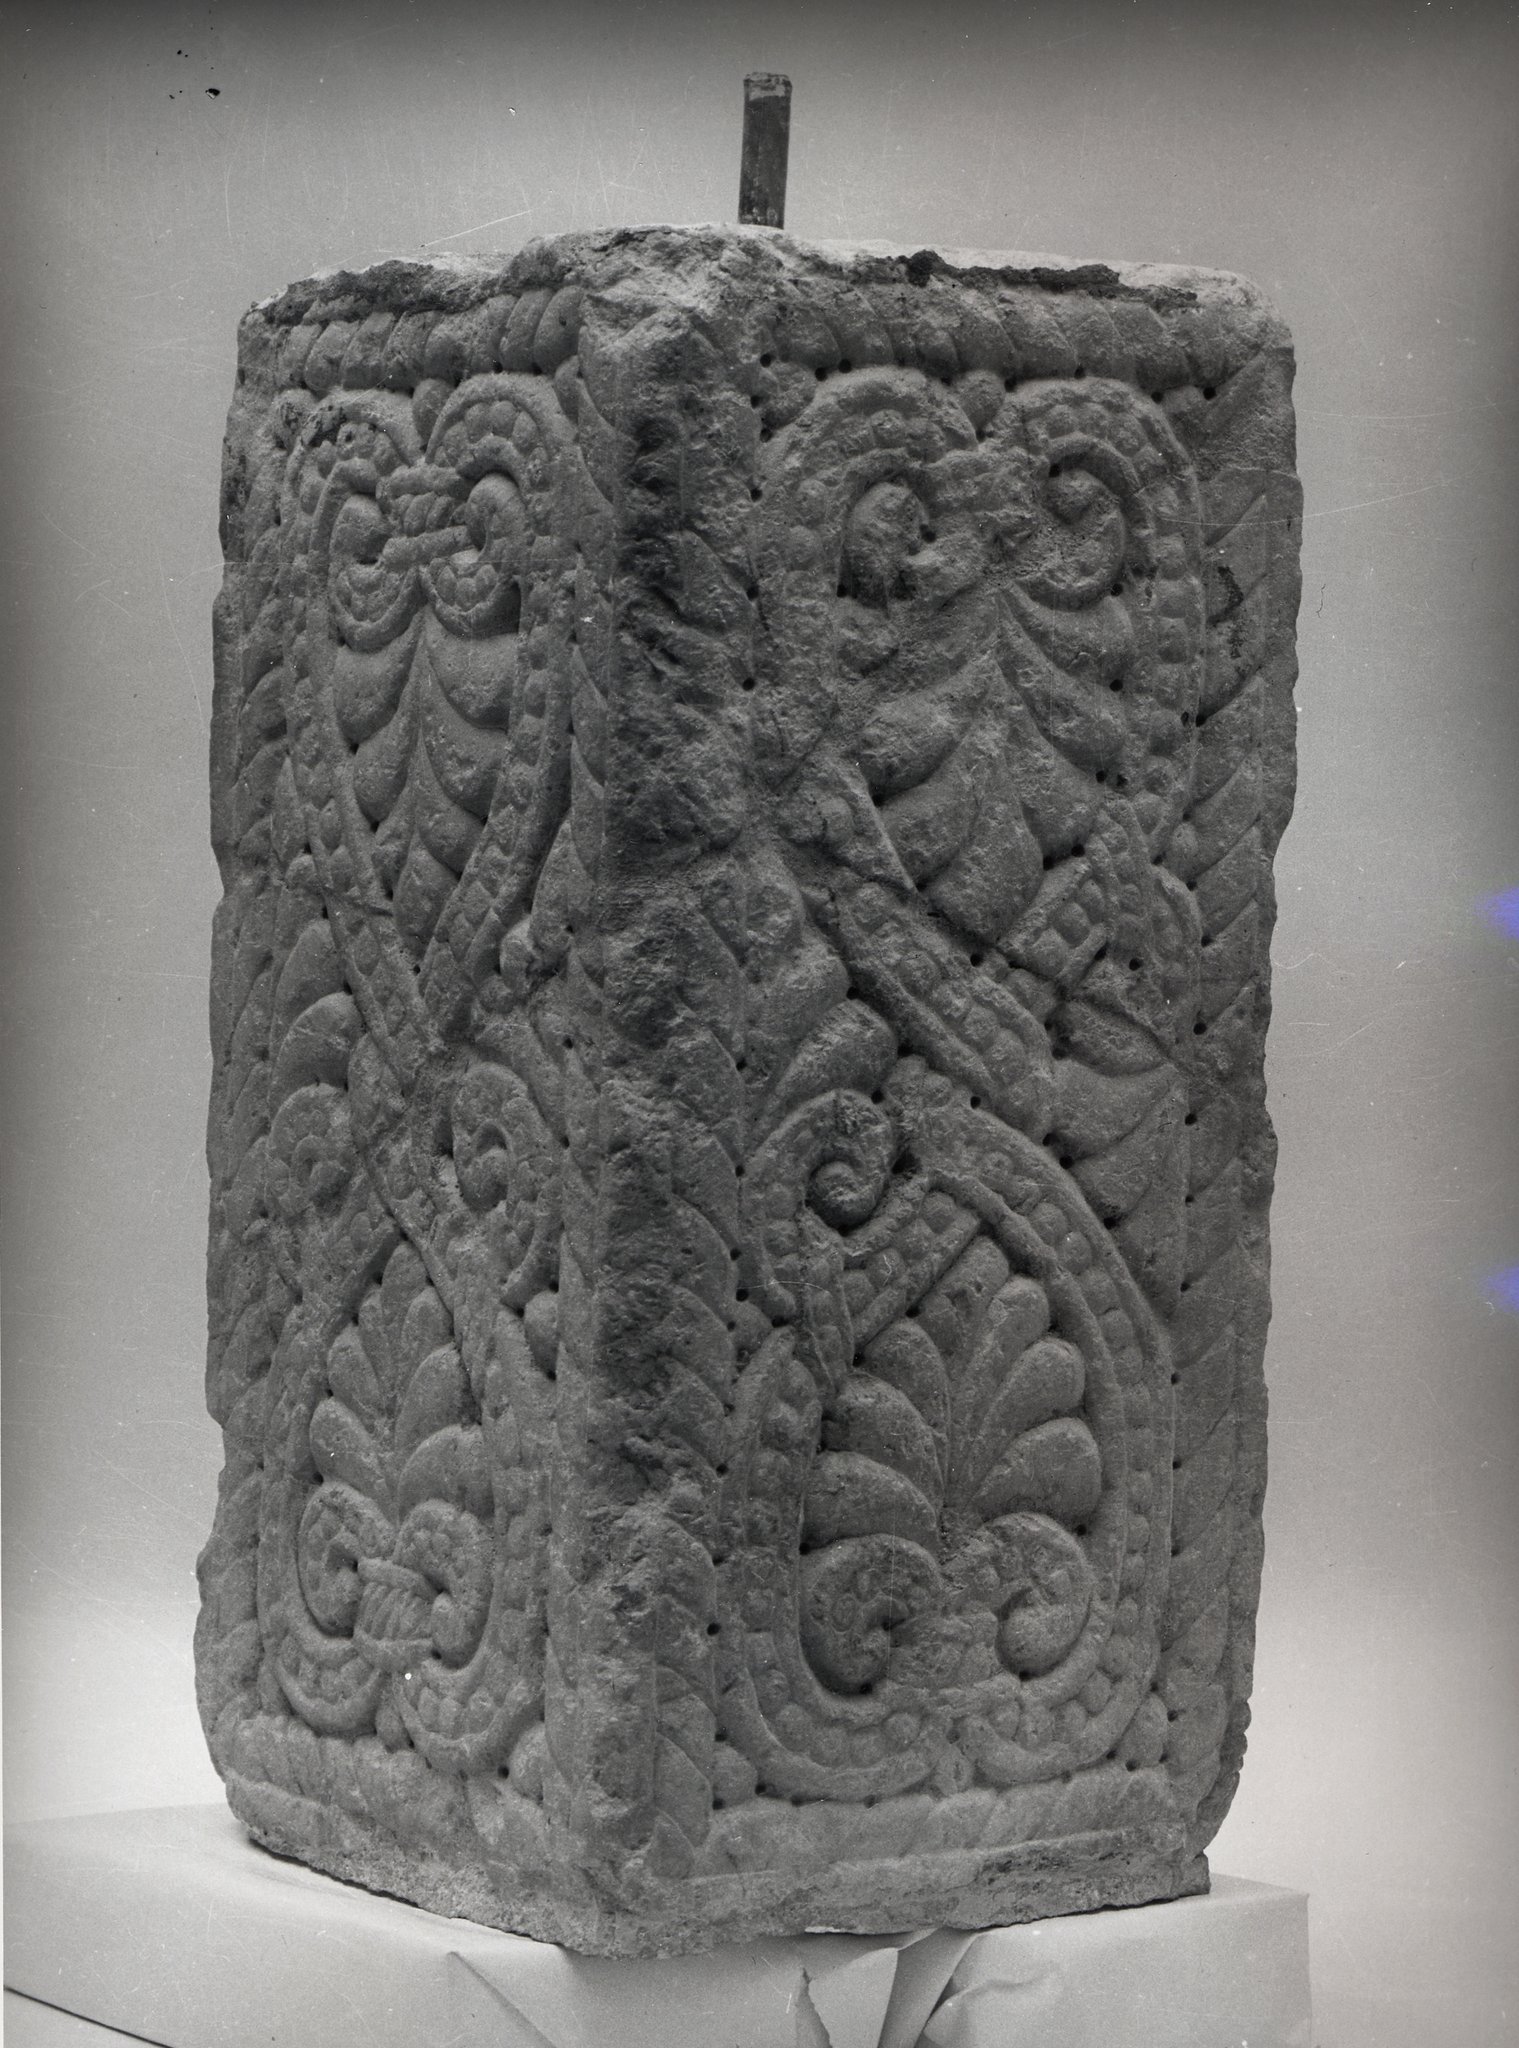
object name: block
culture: catalan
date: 1130-1140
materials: marble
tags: palmettes